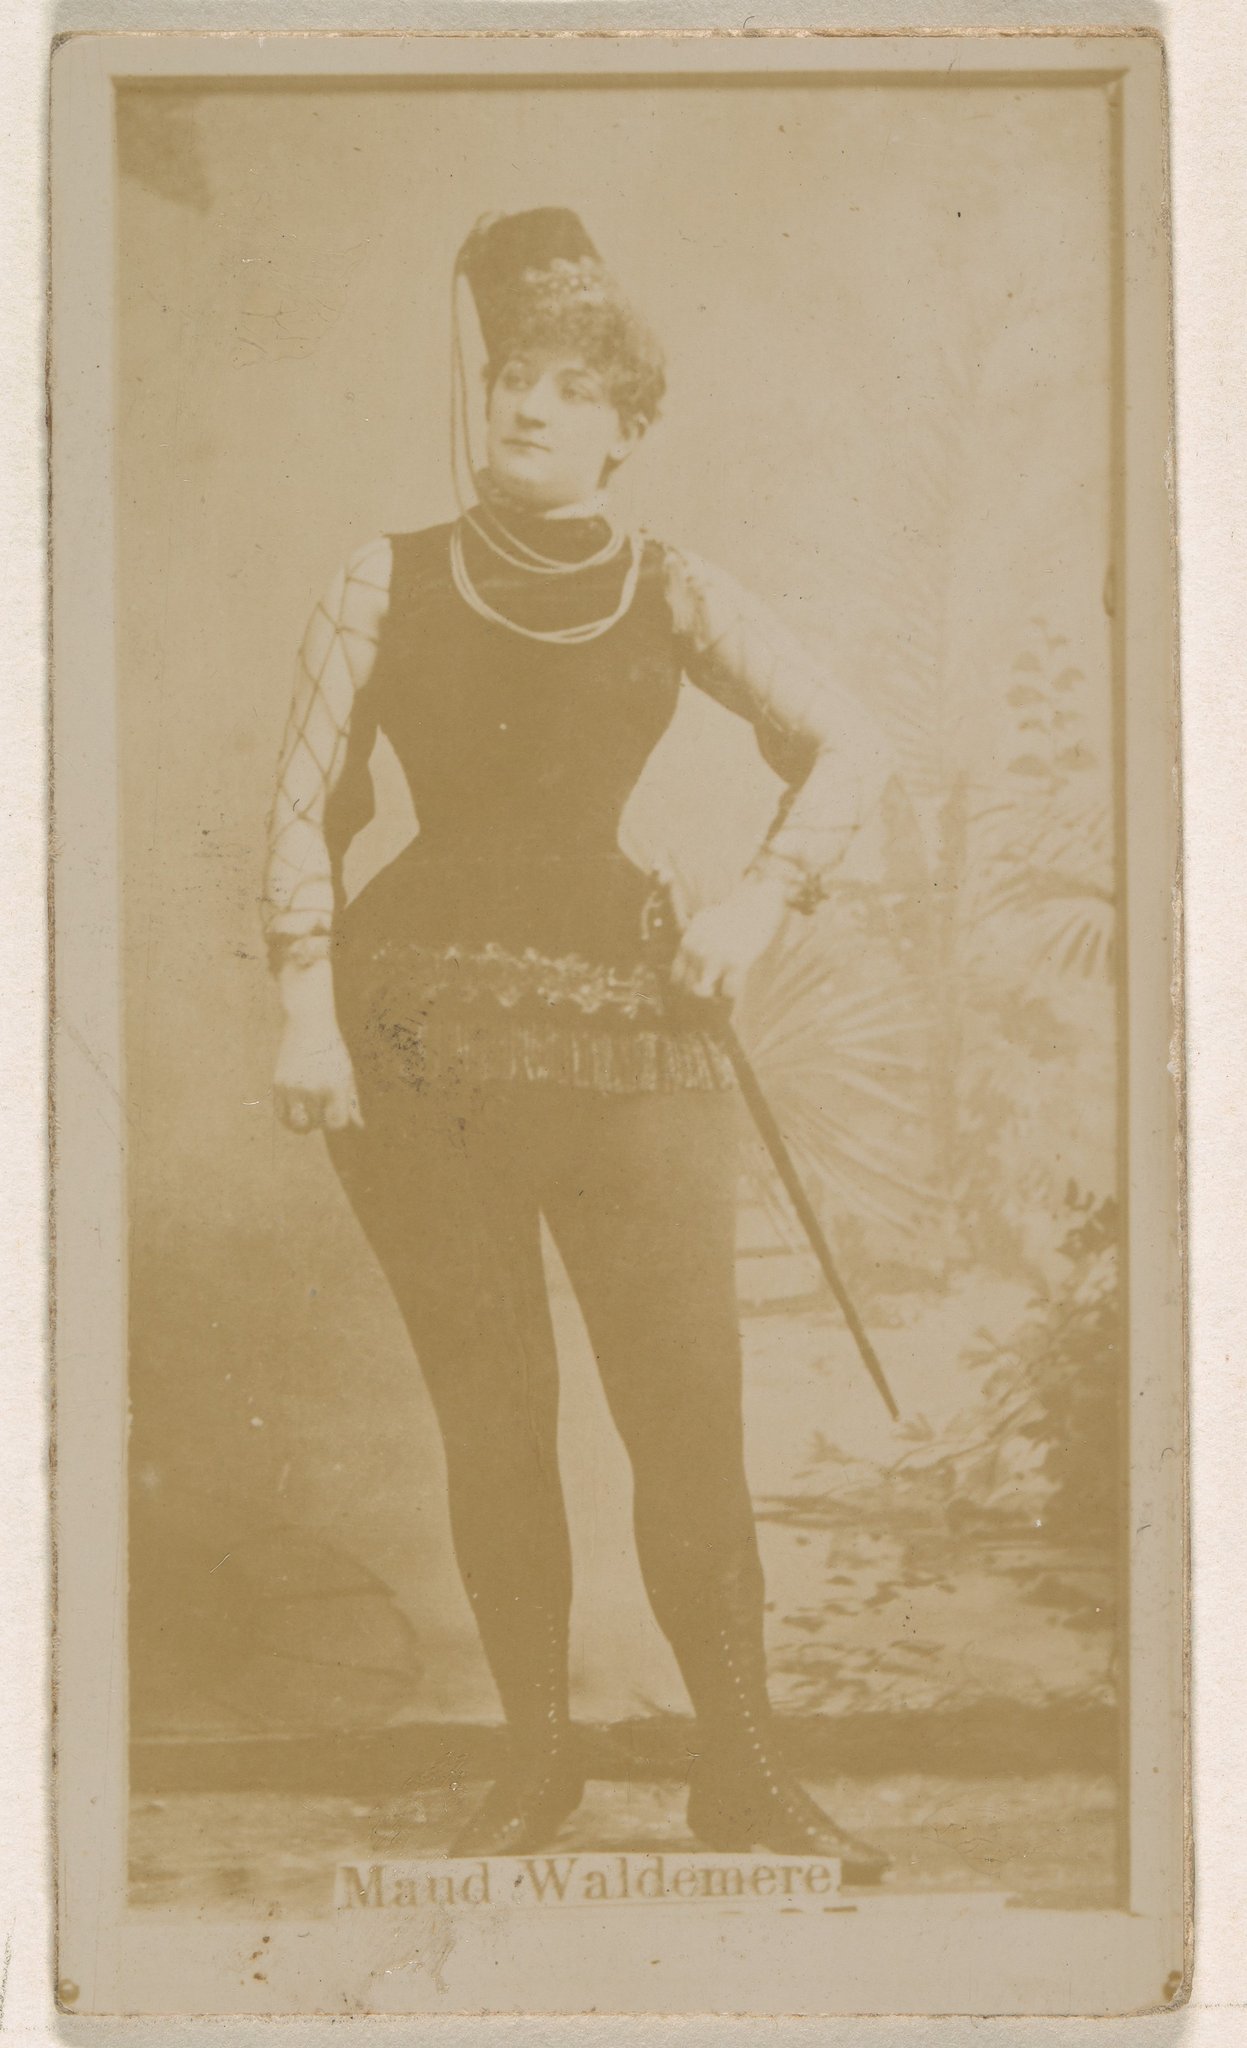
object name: photograph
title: Maud Waldemere, from the Actresses series (N245) issued by Kinney Brothers to promote Sweet Caporal Cigarettes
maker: kinney brothers tobacco company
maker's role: publisher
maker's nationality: american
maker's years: 1869-2011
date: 1890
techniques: albumen silver print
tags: portraits,women,actresses